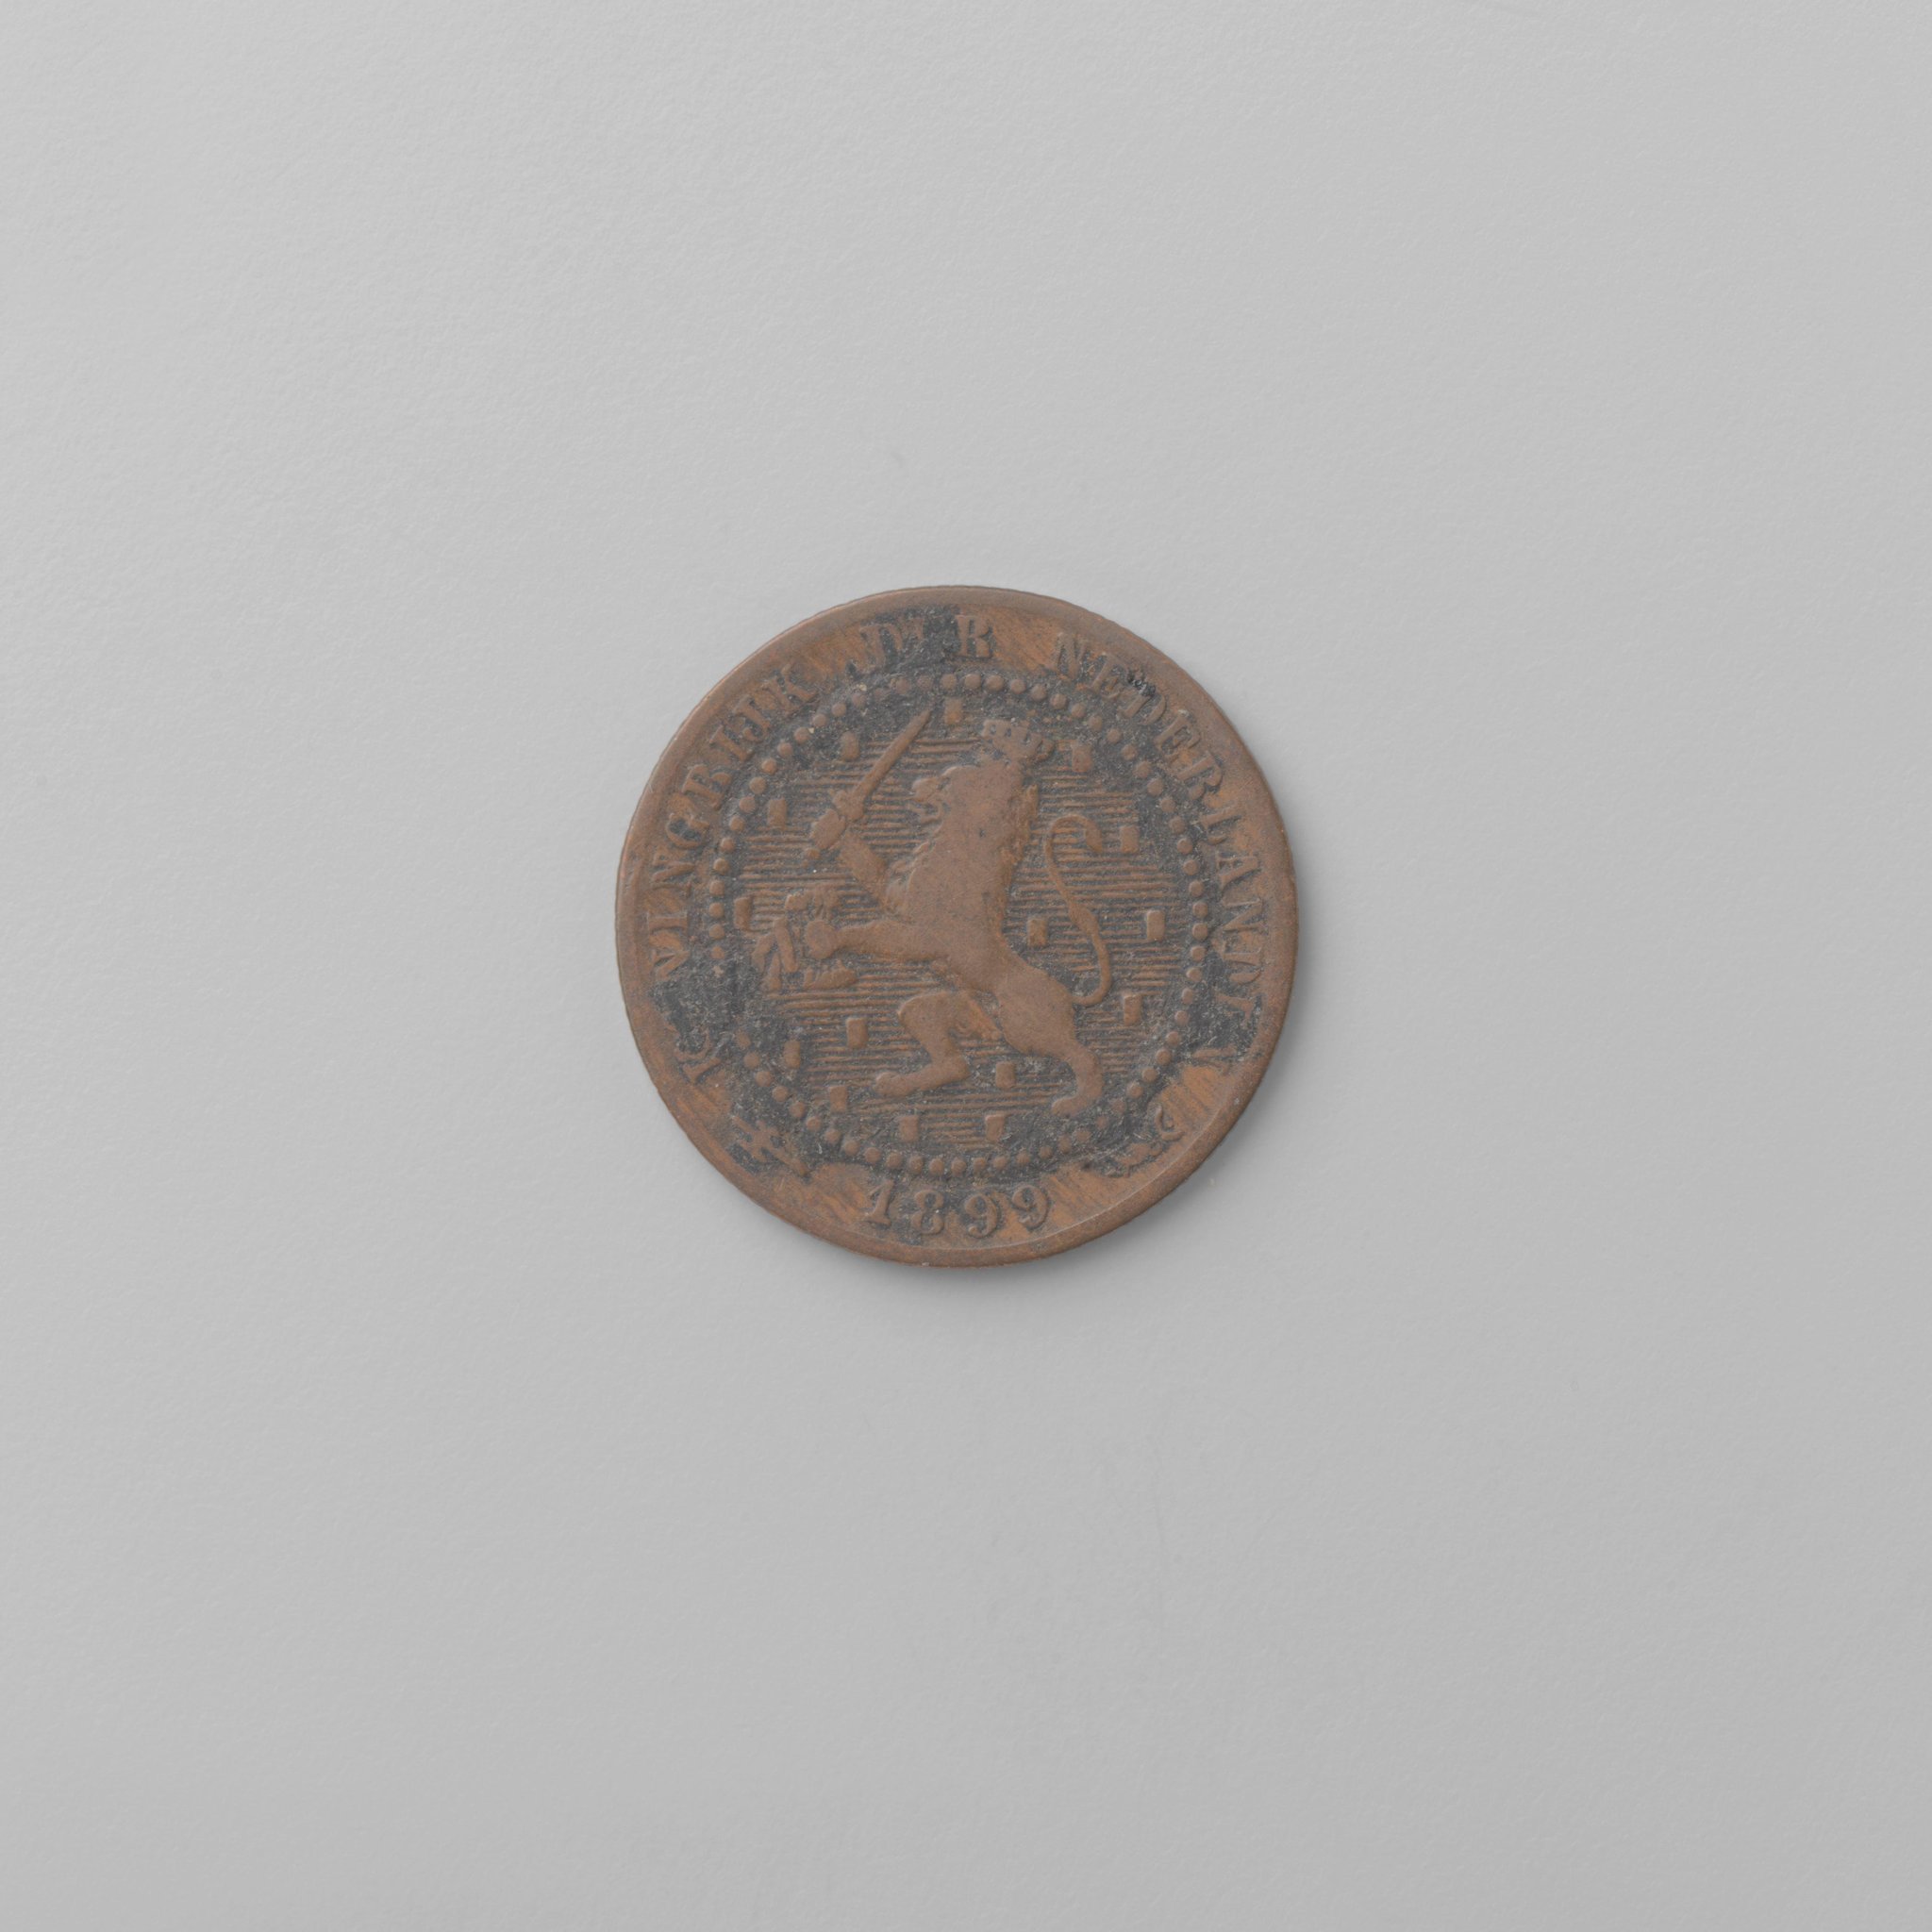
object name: coin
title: Nederland, cent,1899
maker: wilhelmina of the netherlands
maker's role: print maker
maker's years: 1880-1962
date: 1899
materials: bronze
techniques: striking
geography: utrecht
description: Bronzen munt. Voorzijde: in een veld rijkswapen. Jaartal onderaan in omschrift. Keerzijde: binnen twee samengebonden oranjetakken waarde-aanduiding 1 cent. Kartelrand.